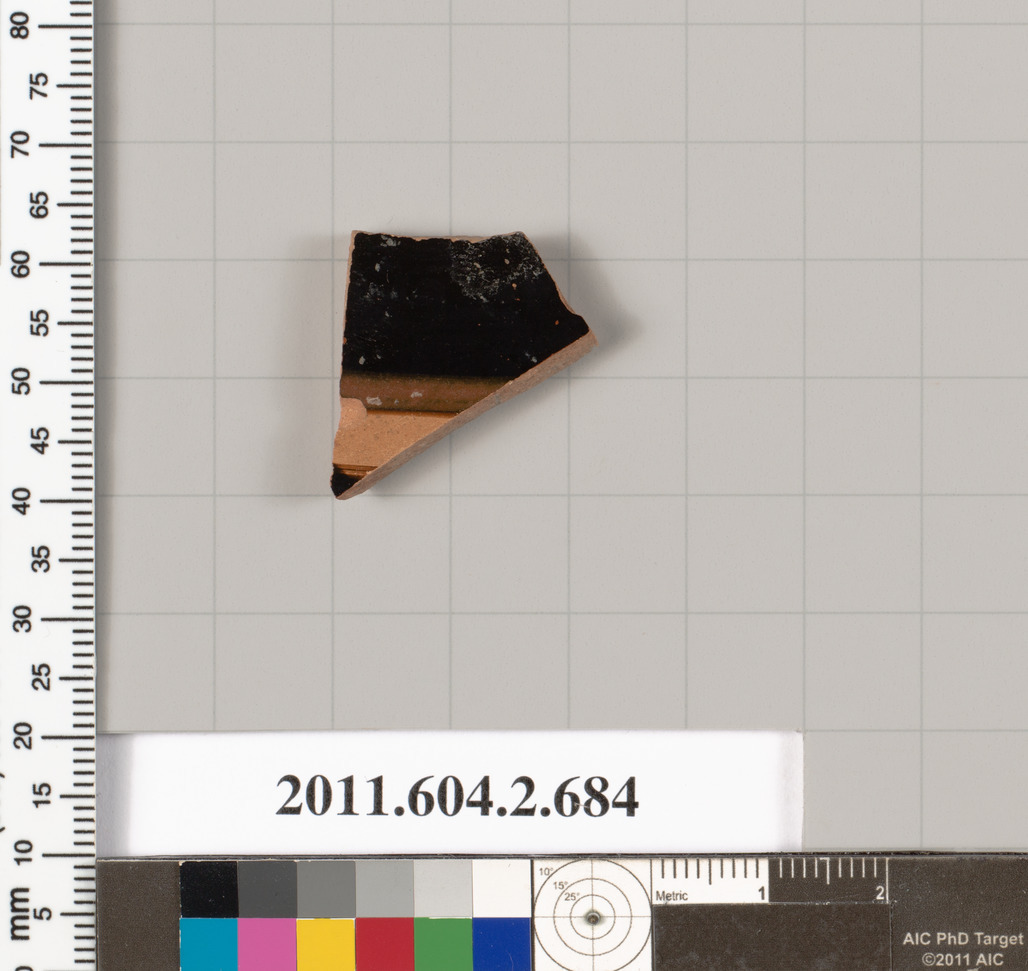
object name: column krater fragment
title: Terracotta fragment of a column-krater (bowl for mixing wine and water)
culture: greek, attic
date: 475-440 BCE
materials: terracotta